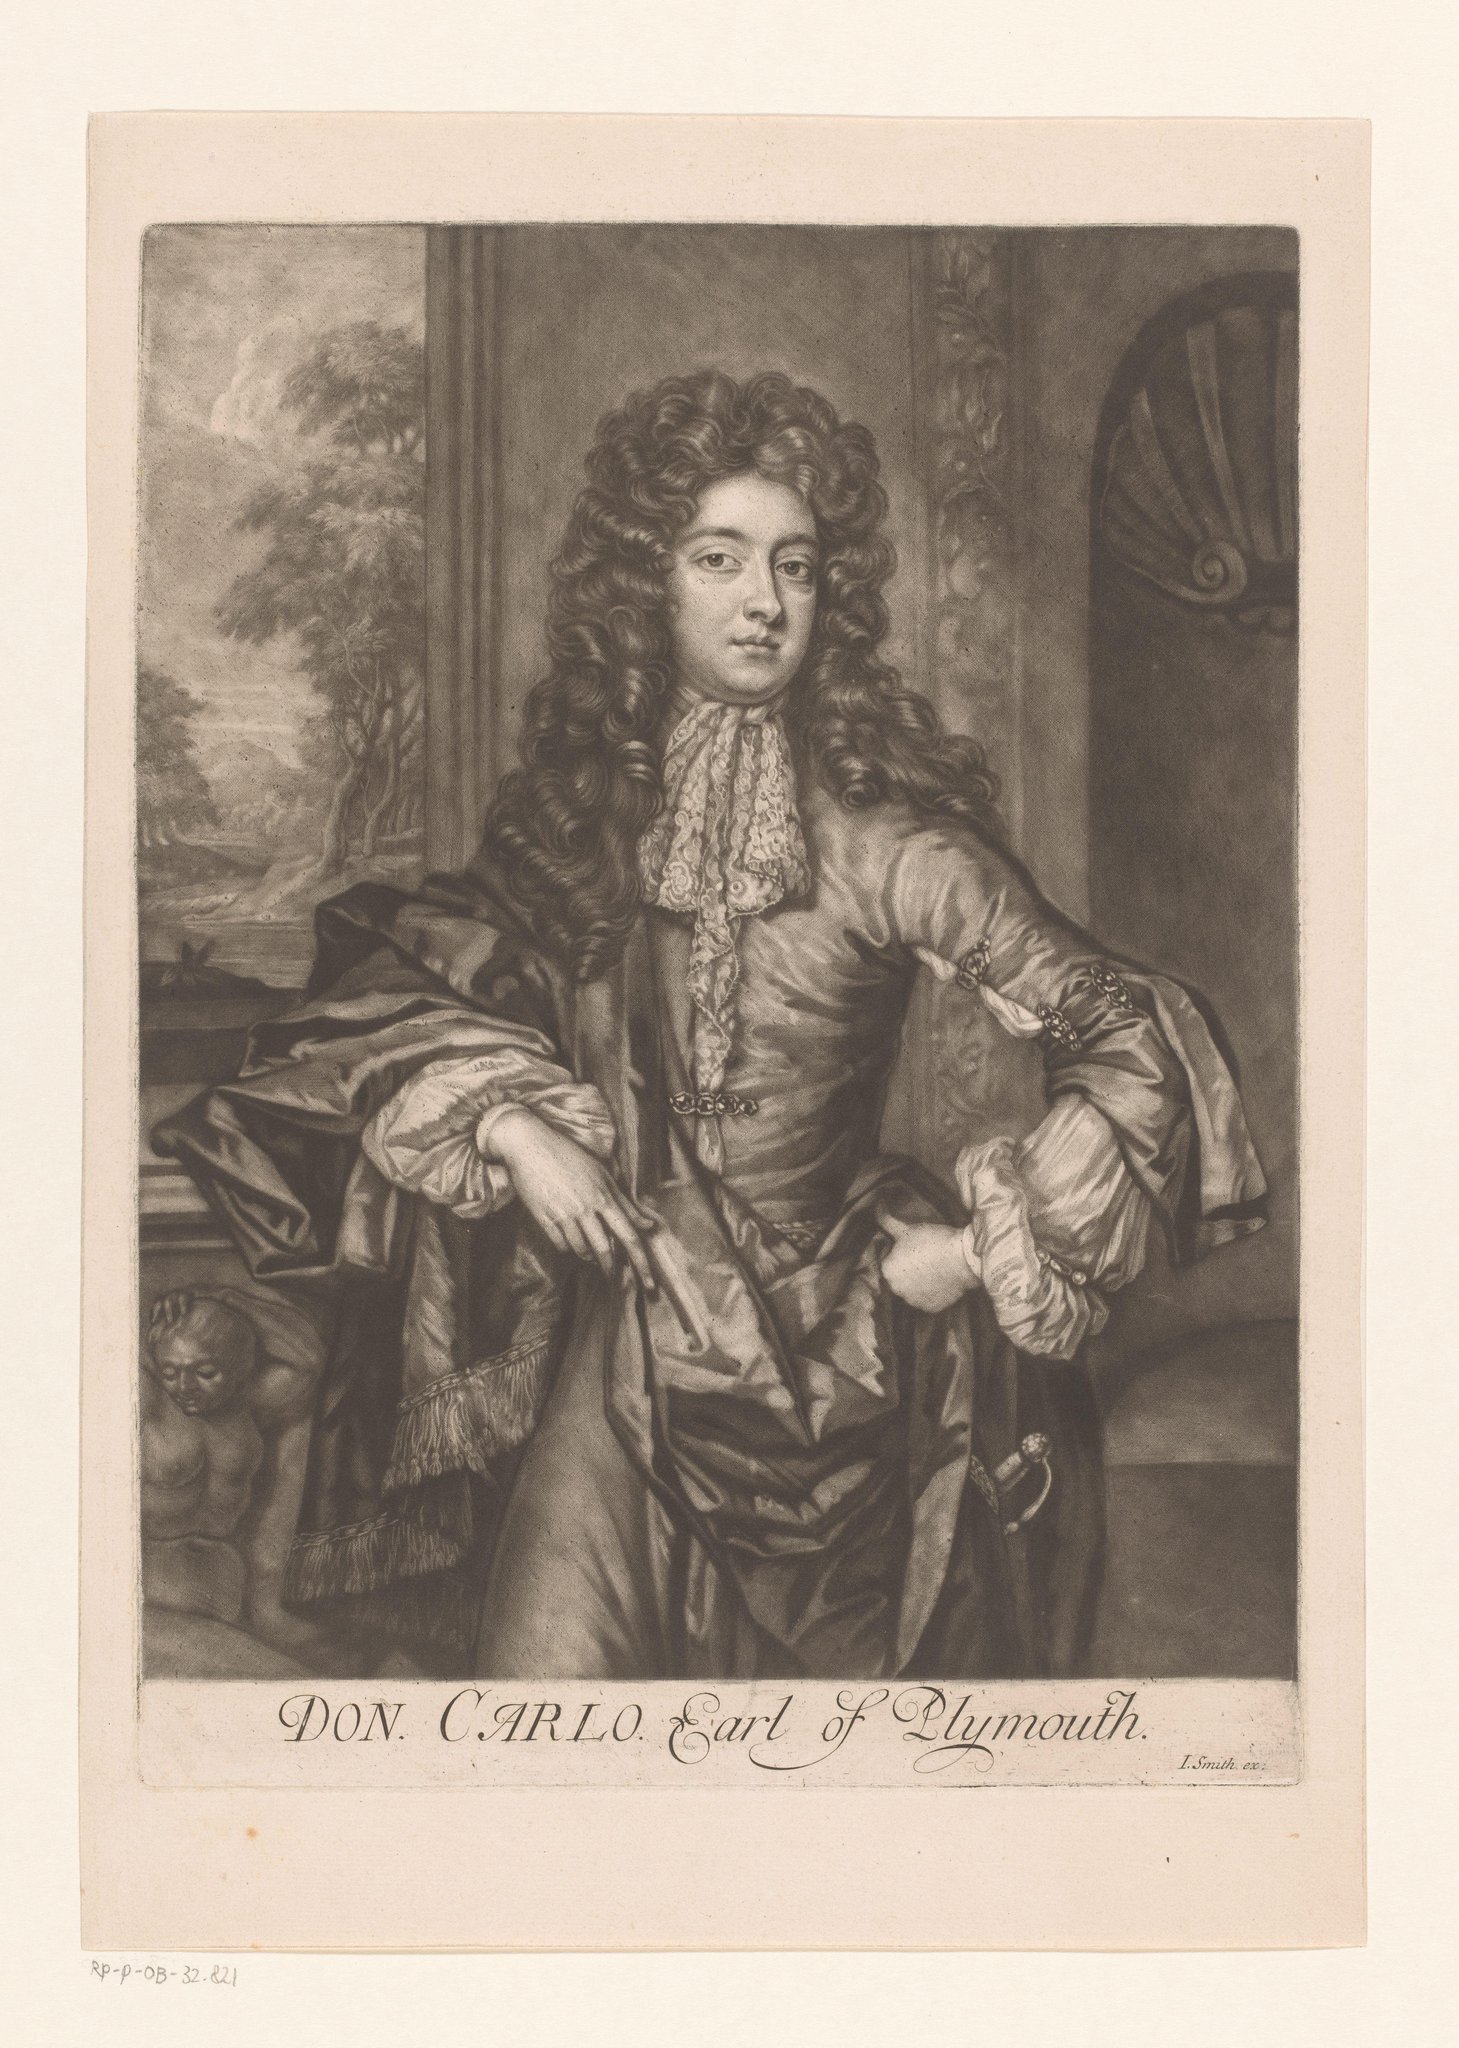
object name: print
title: Portret van Charles FitzCharles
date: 1667-1742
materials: paper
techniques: mezzotint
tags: historical persons, officer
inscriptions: collector's mark: Lugt 240